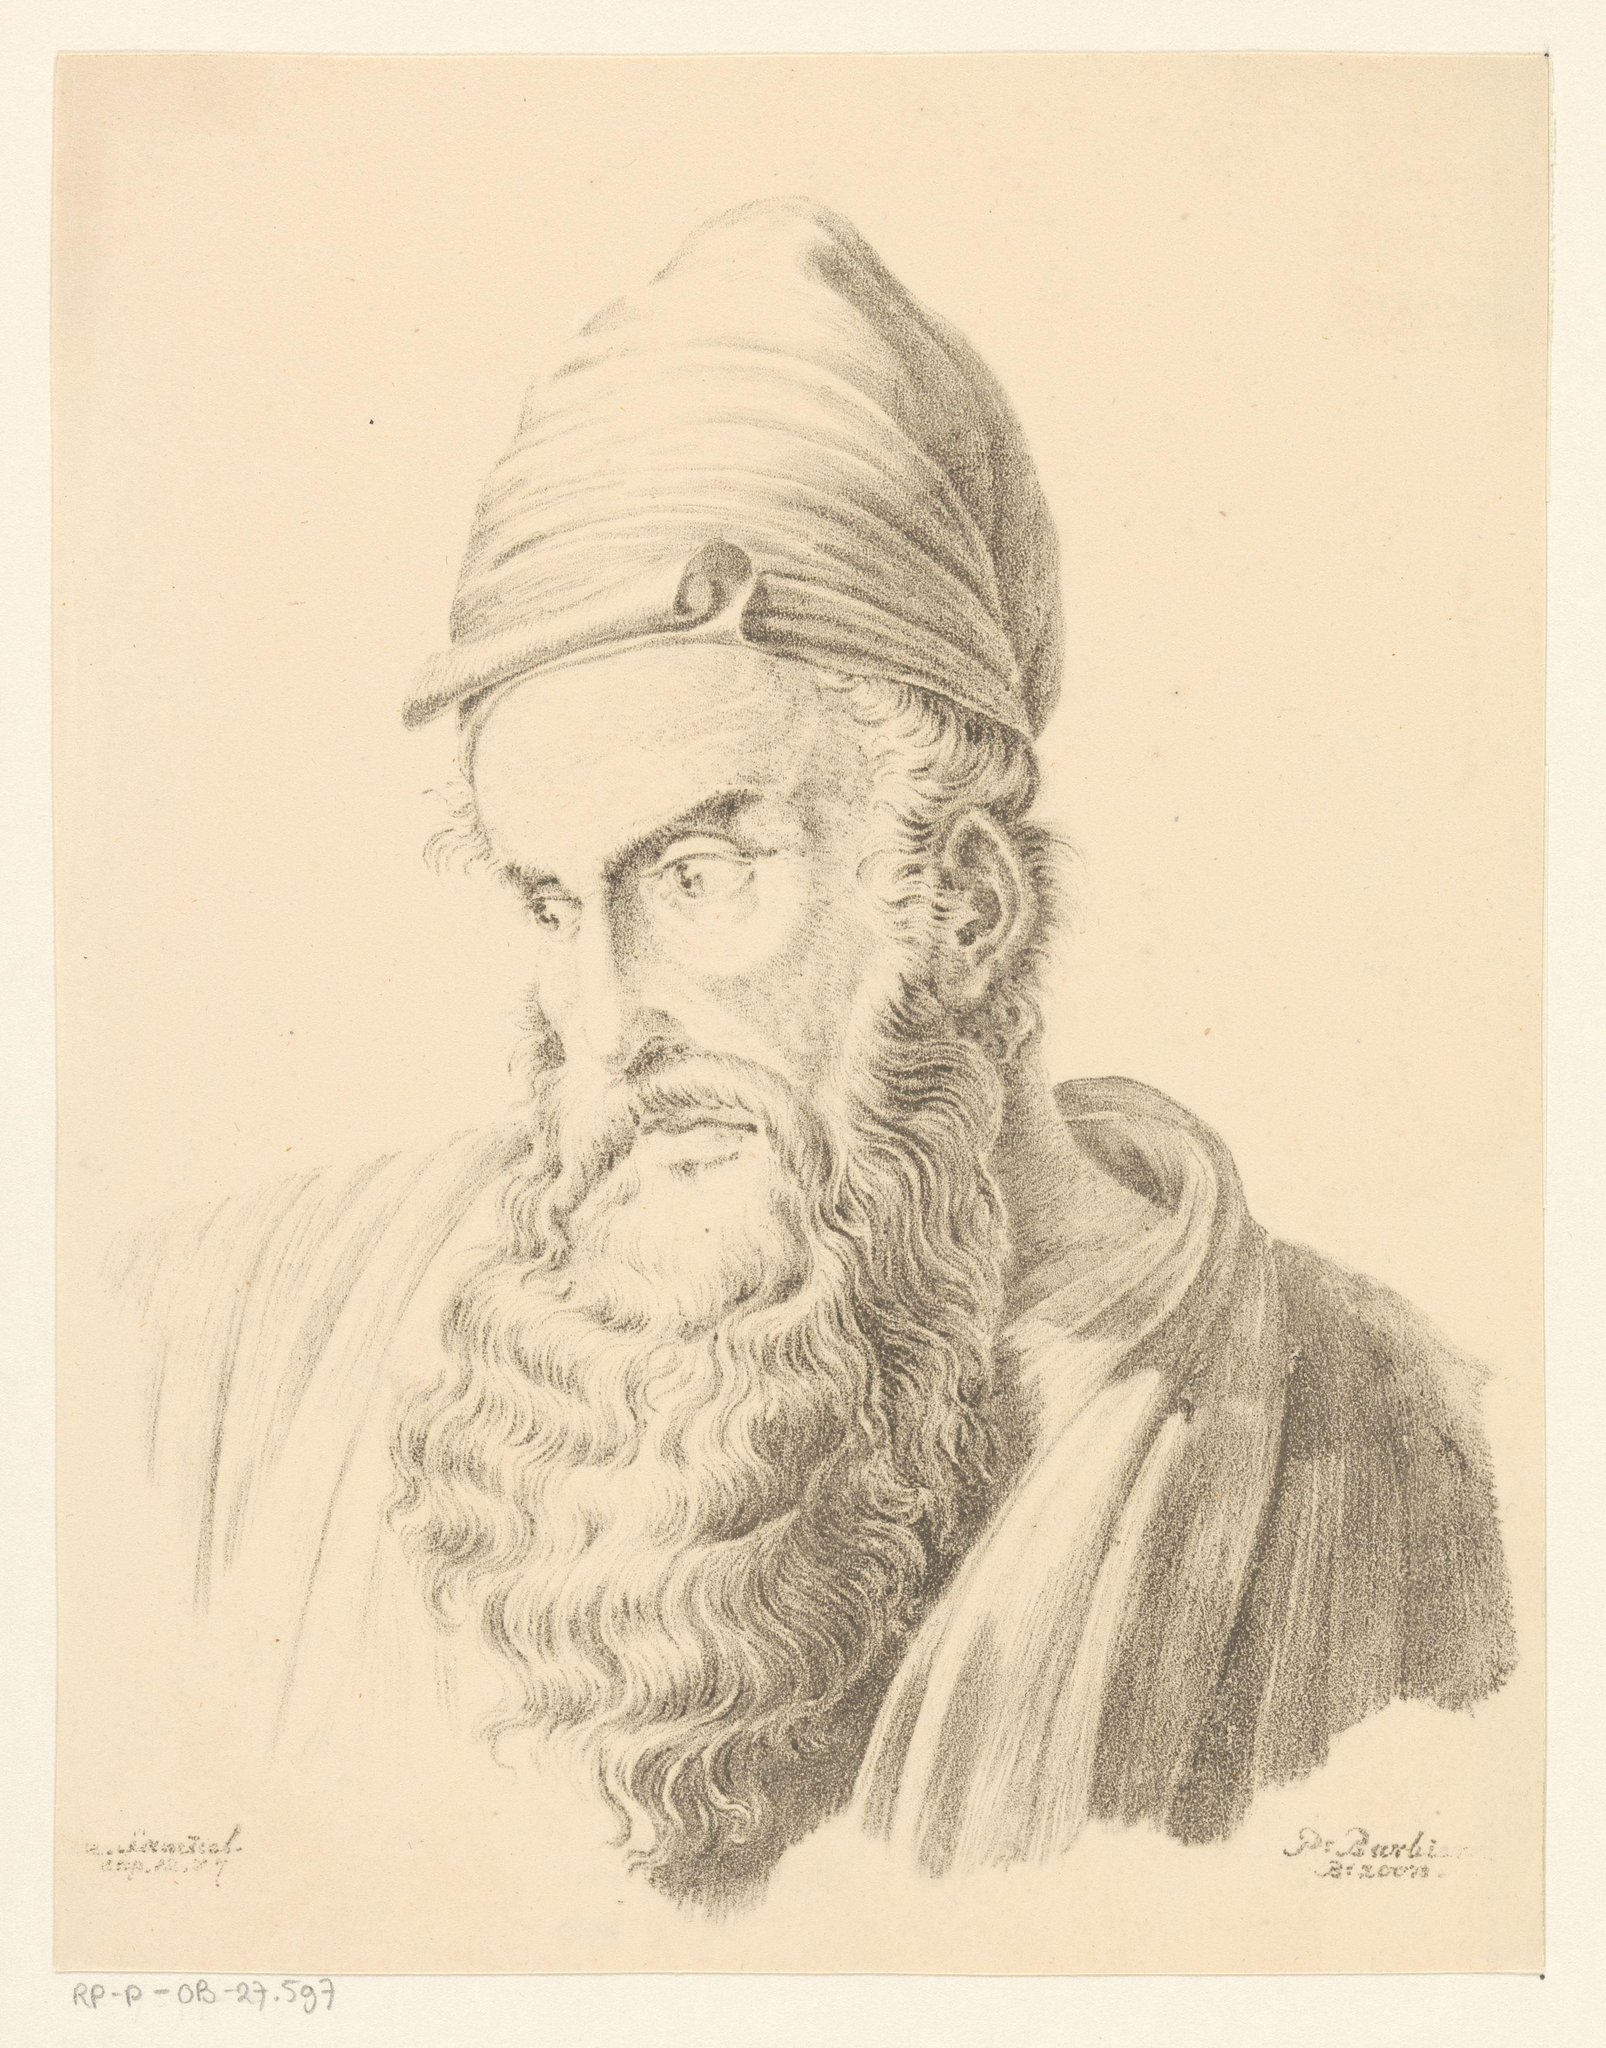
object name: print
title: Portret van een onbekende man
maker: pieter bartholomeusz. barbiers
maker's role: draughtsman, print maker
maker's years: 1772-1837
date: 1809-1837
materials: paper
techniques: lithograph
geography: haarlem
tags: head (human) (+ positions (of the human figure)), looking downwards (+ three-quarter view), head-gear: cap, beard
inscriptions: collector's mark: Lugt 2228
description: De man draagt een muts met een opkrullende rand aan de voorkant. Hij heeft een lange baard en zijn blik naar beneden gericht.